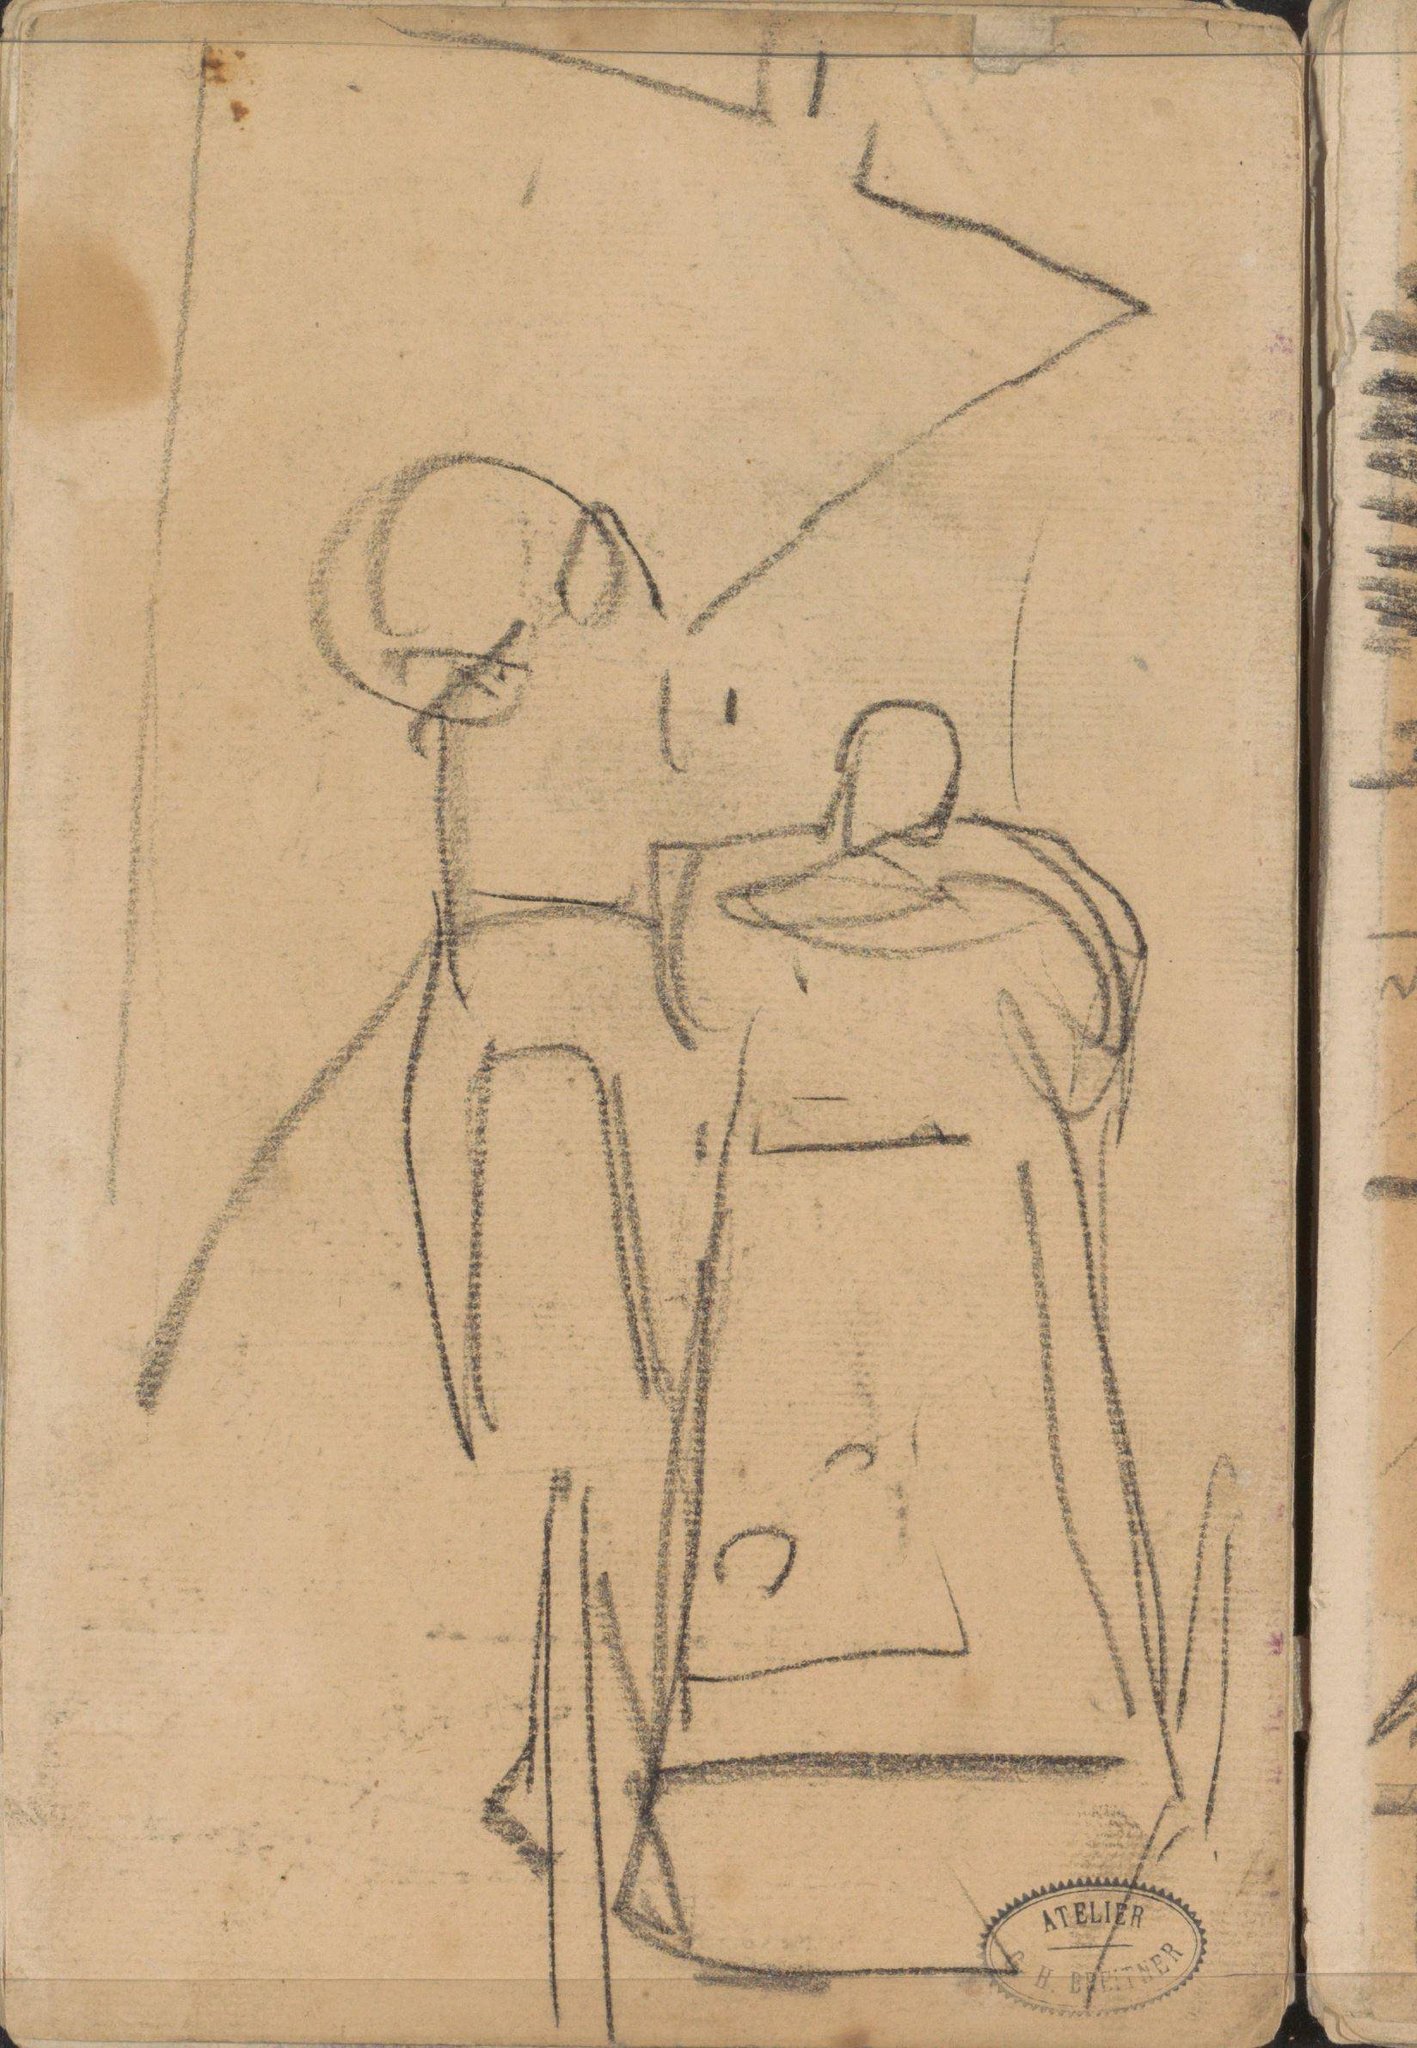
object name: sketchbook leaf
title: Kar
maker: george hendrik breitner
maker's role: draughtsman, painter, print maker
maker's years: 1857-1923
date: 1886-1923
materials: chalk, paper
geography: amsterdam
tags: (farm) wagon, freight wagon, cart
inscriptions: workshop stamp: Lugt 291d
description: Pagina 17 uit een schetsboek met 19 bladen en 9 losse tekeningen.